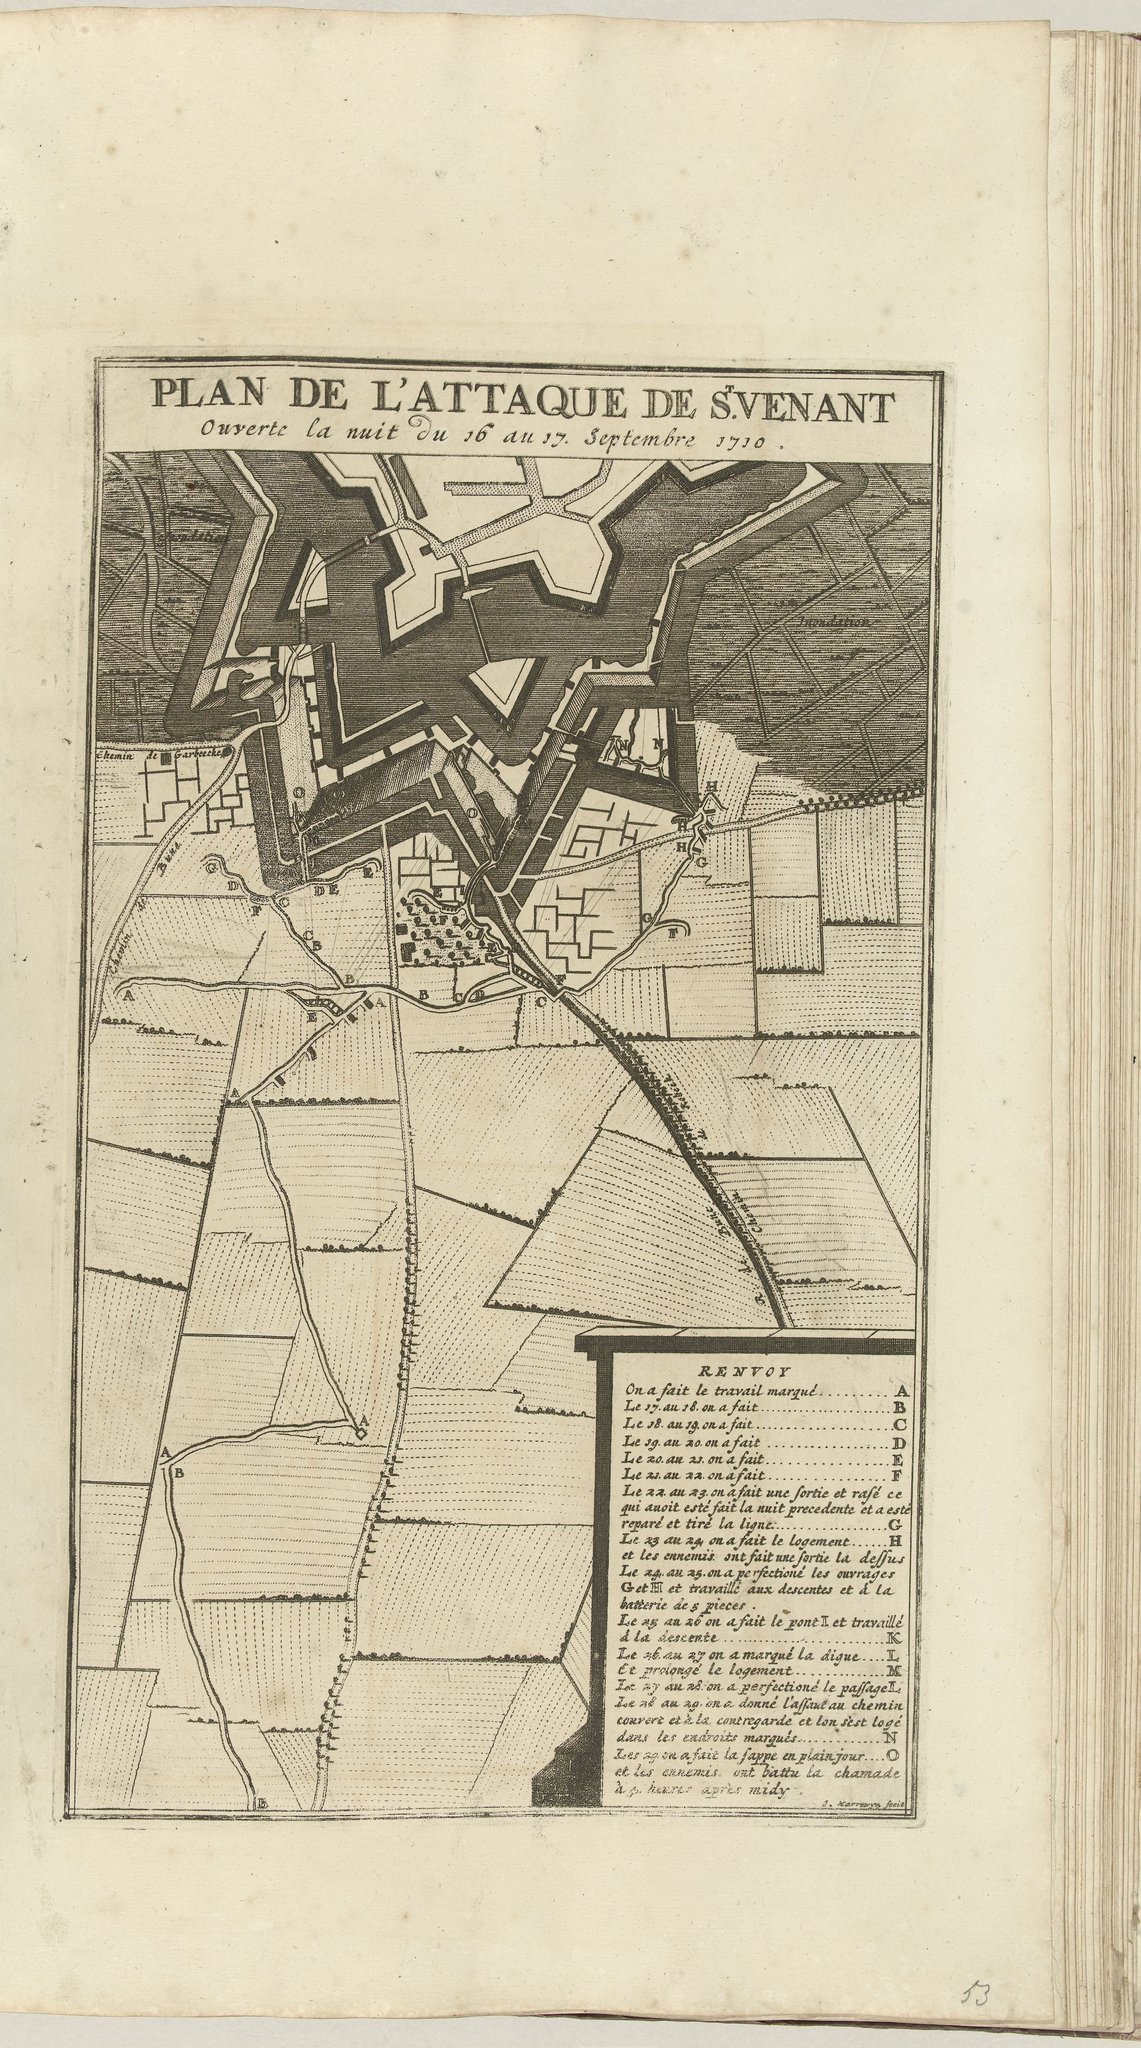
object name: print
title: Beleg van Saint-Venant, 1710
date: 1710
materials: paper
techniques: etching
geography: brussels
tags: siege, position war, maps of cities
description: Detailvoorstelling van de eerste aanvallen door de Geallieerden op Saint-Venant, in de nacht van 16 op 17 september 1710. Rechtsonder een cartouche met de legenda A-O in het Frans. Onderdeel van een gebundelde verzameling van plannen van veldslagen en steden vermaard in de Spaanse Successieoorlog.